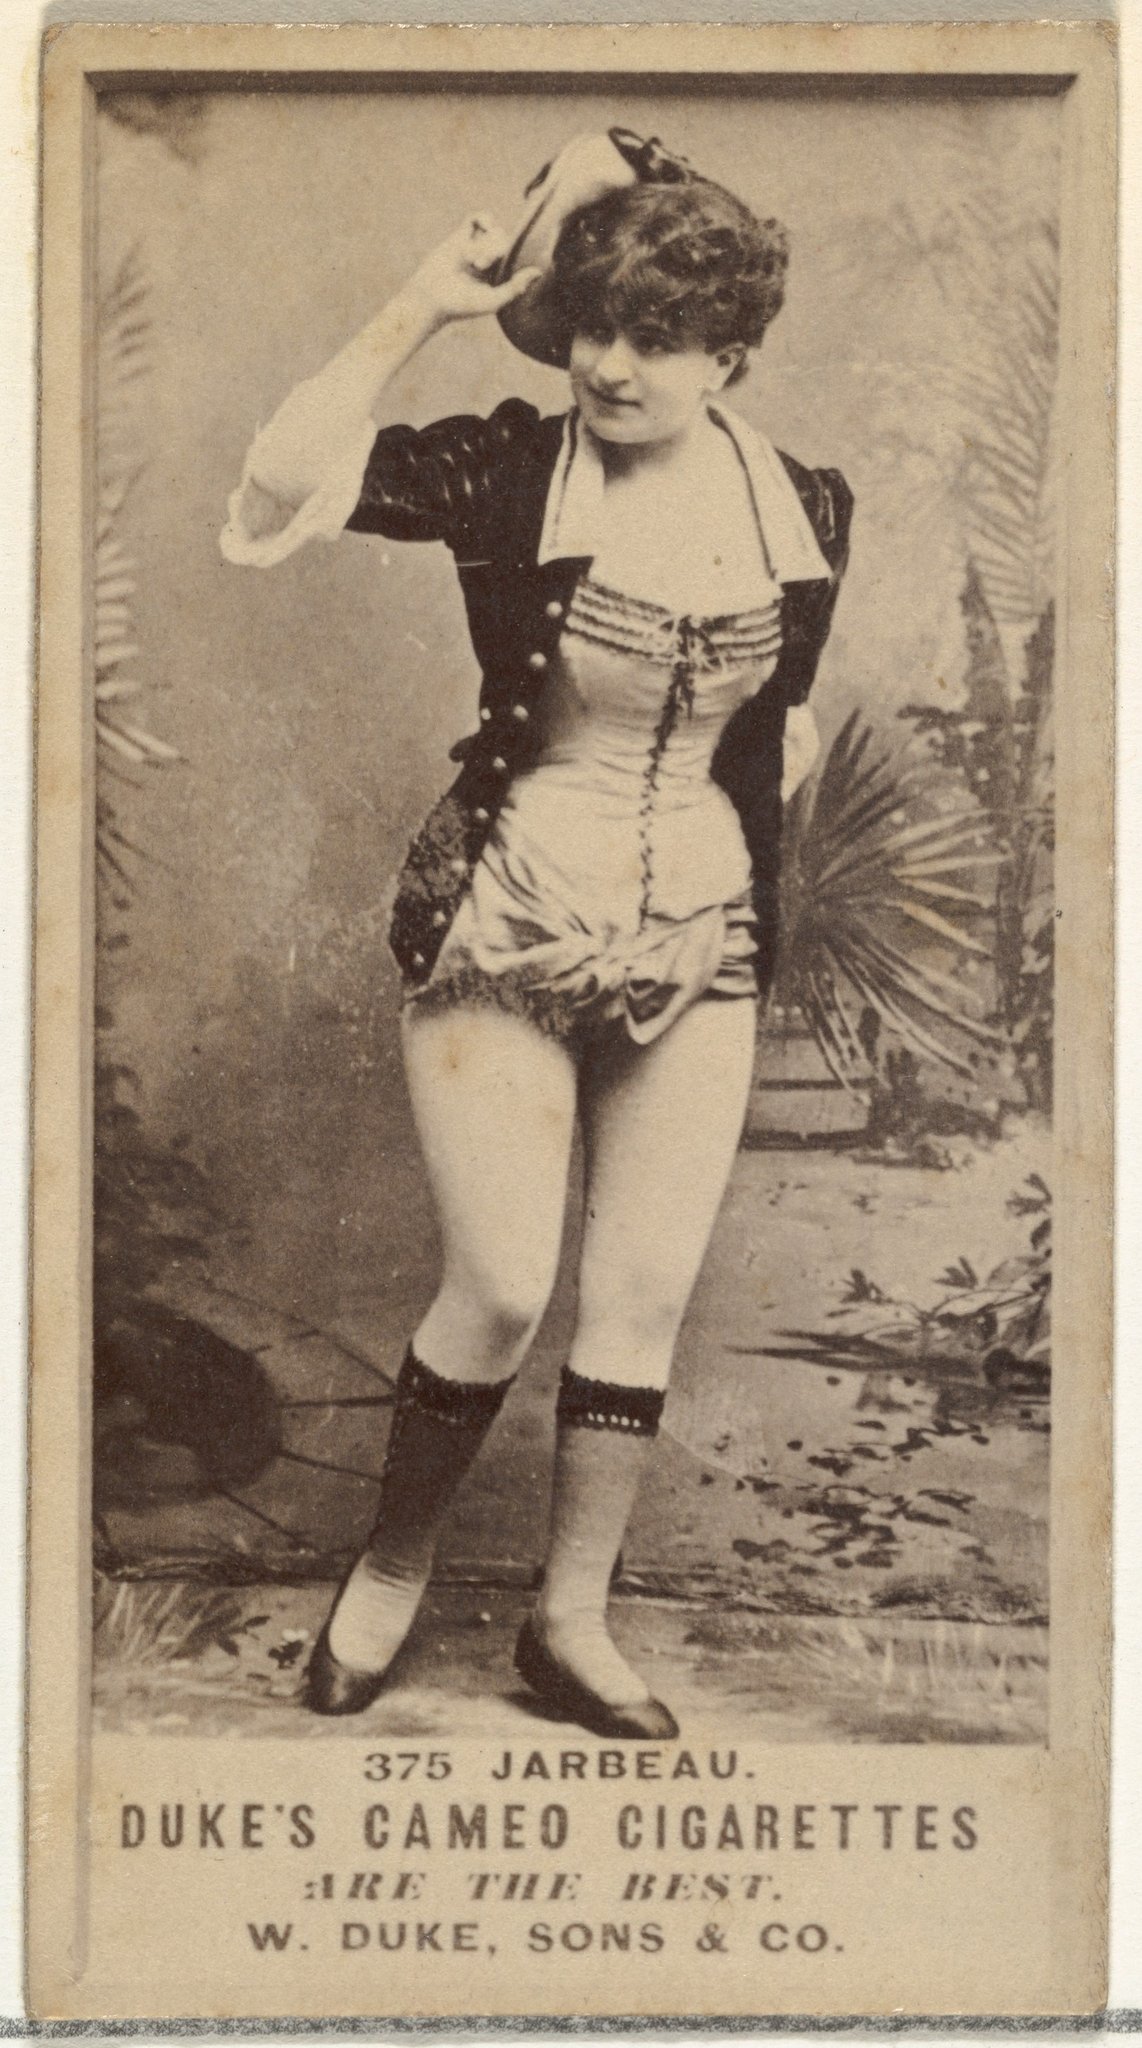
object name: photograph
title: Card Number 375, Miss Jarbeau, from the Actors and Actresses series (N145-5) issued by Duke Sons & Co. to promote Cameo Cigarettes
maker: w. duke, sons & co.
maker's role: publisher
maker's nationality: american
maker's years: 1870-1920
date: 1880-1889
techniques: albumen silver print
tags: portraits,women,actresses